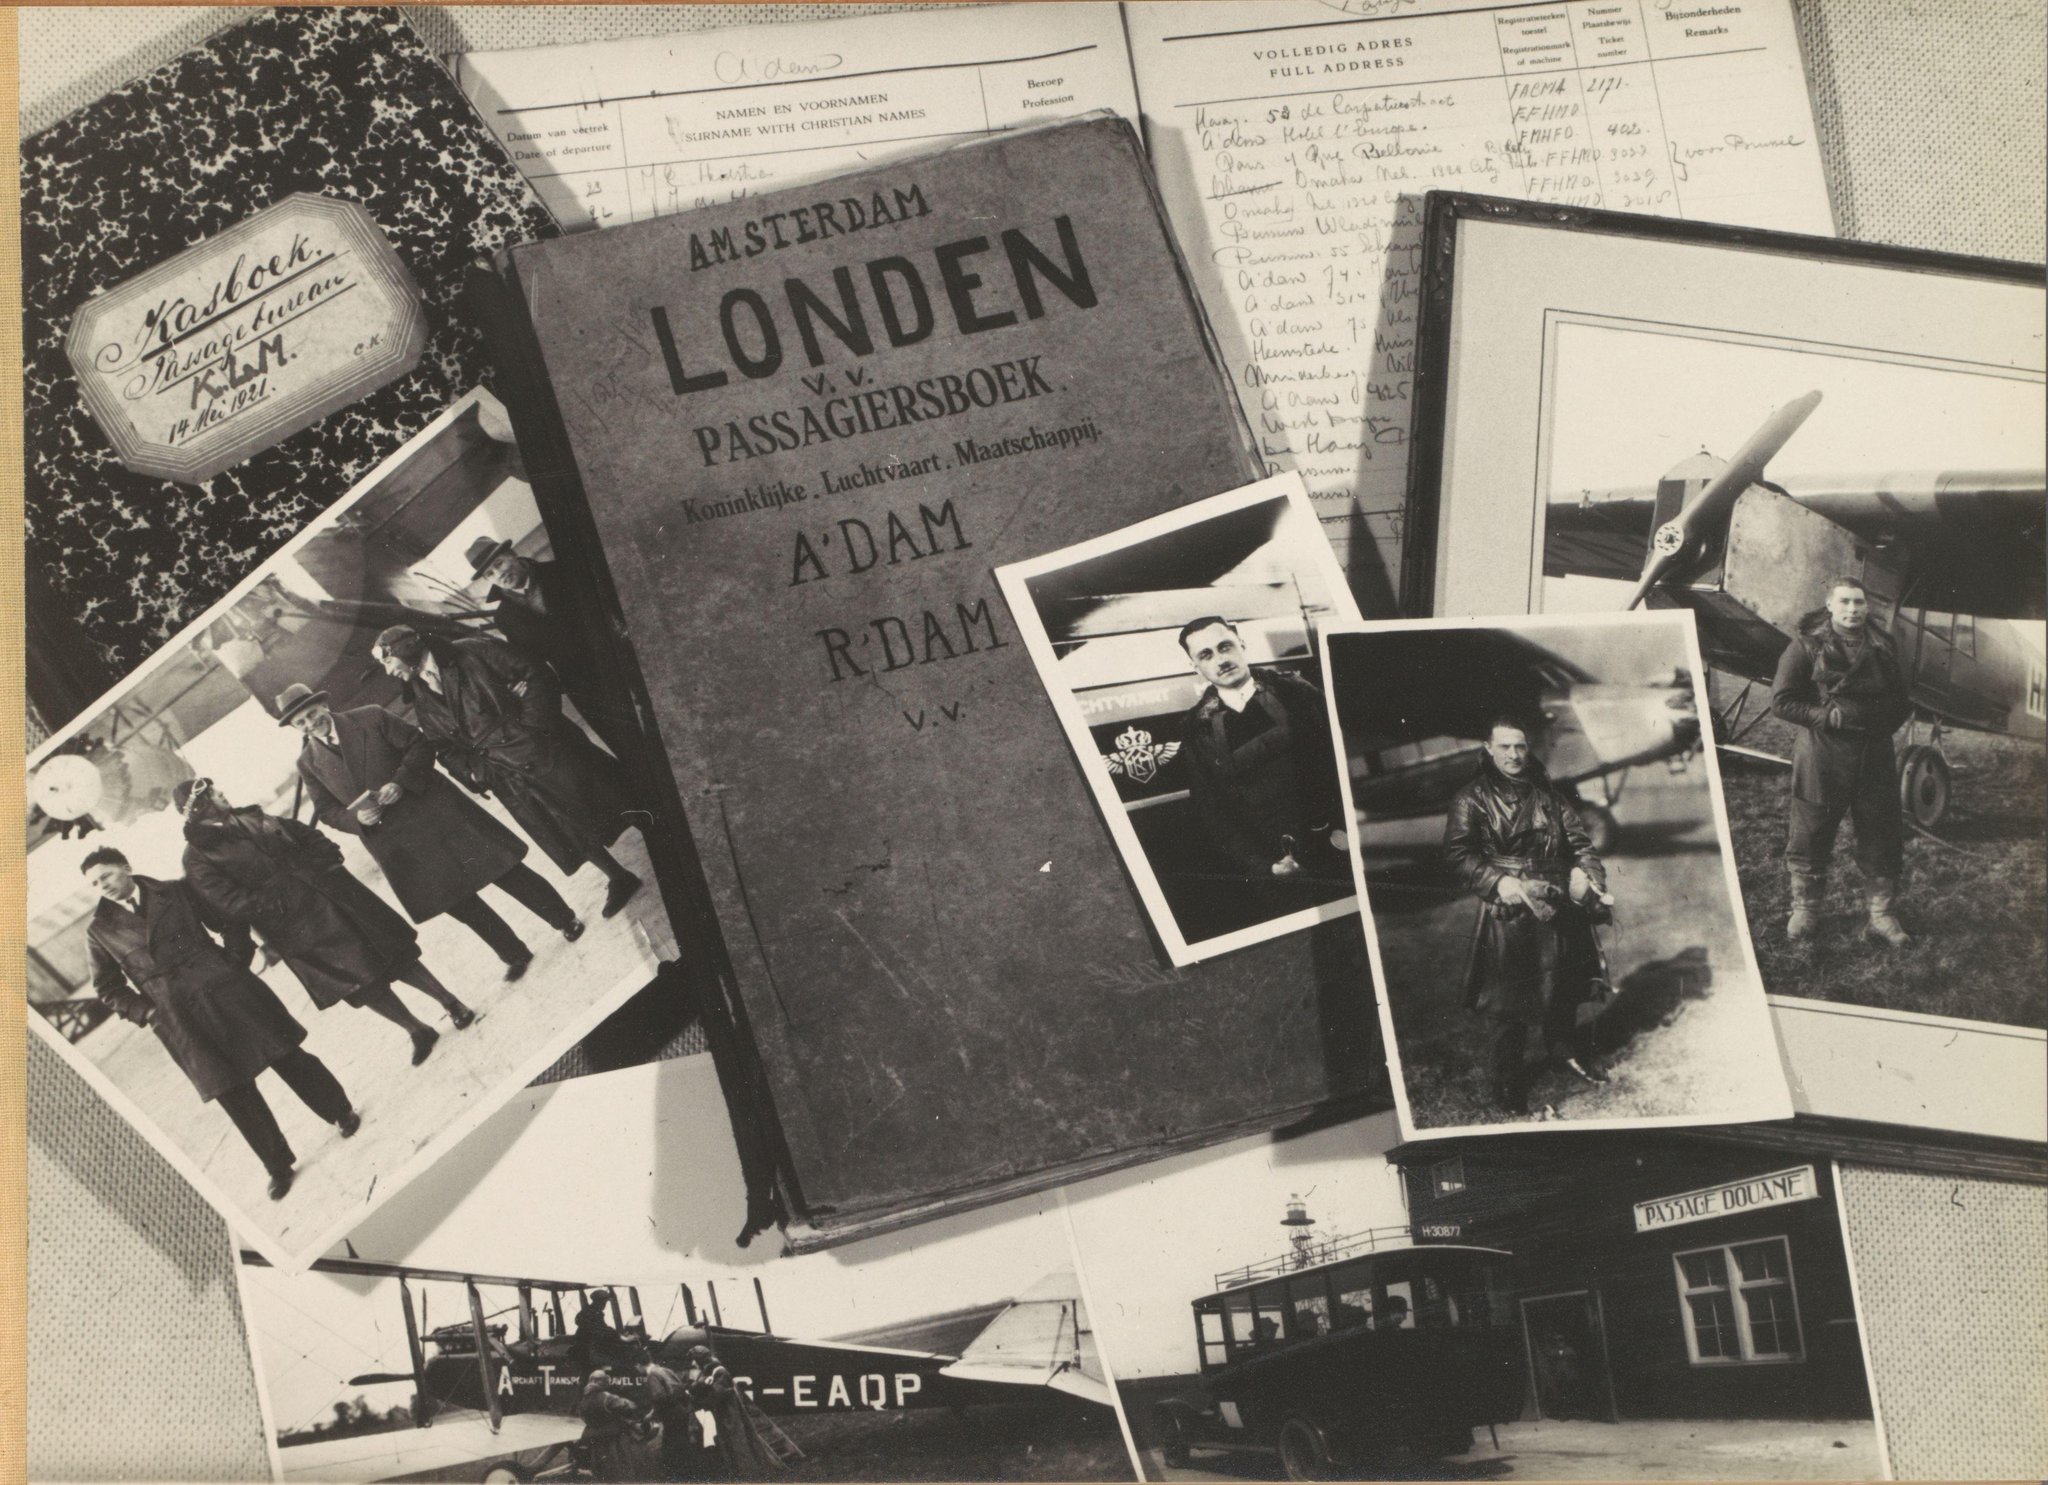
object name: photograph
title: KLM-piloten en administratieboeken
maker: Anonymous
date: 1949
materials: cardboard, paper, photographic support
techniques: gelatin silver print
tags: airborne traffic, aviation, pilot, flight crew, book, travelling; tourism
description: Albumblad met een compositiefoto van een passagiersboek, een kasboek, een passagierslijst en van piloten. Onderdeel van Herdenkingsalbum van de Indië-lijn van de KLM, deel I.